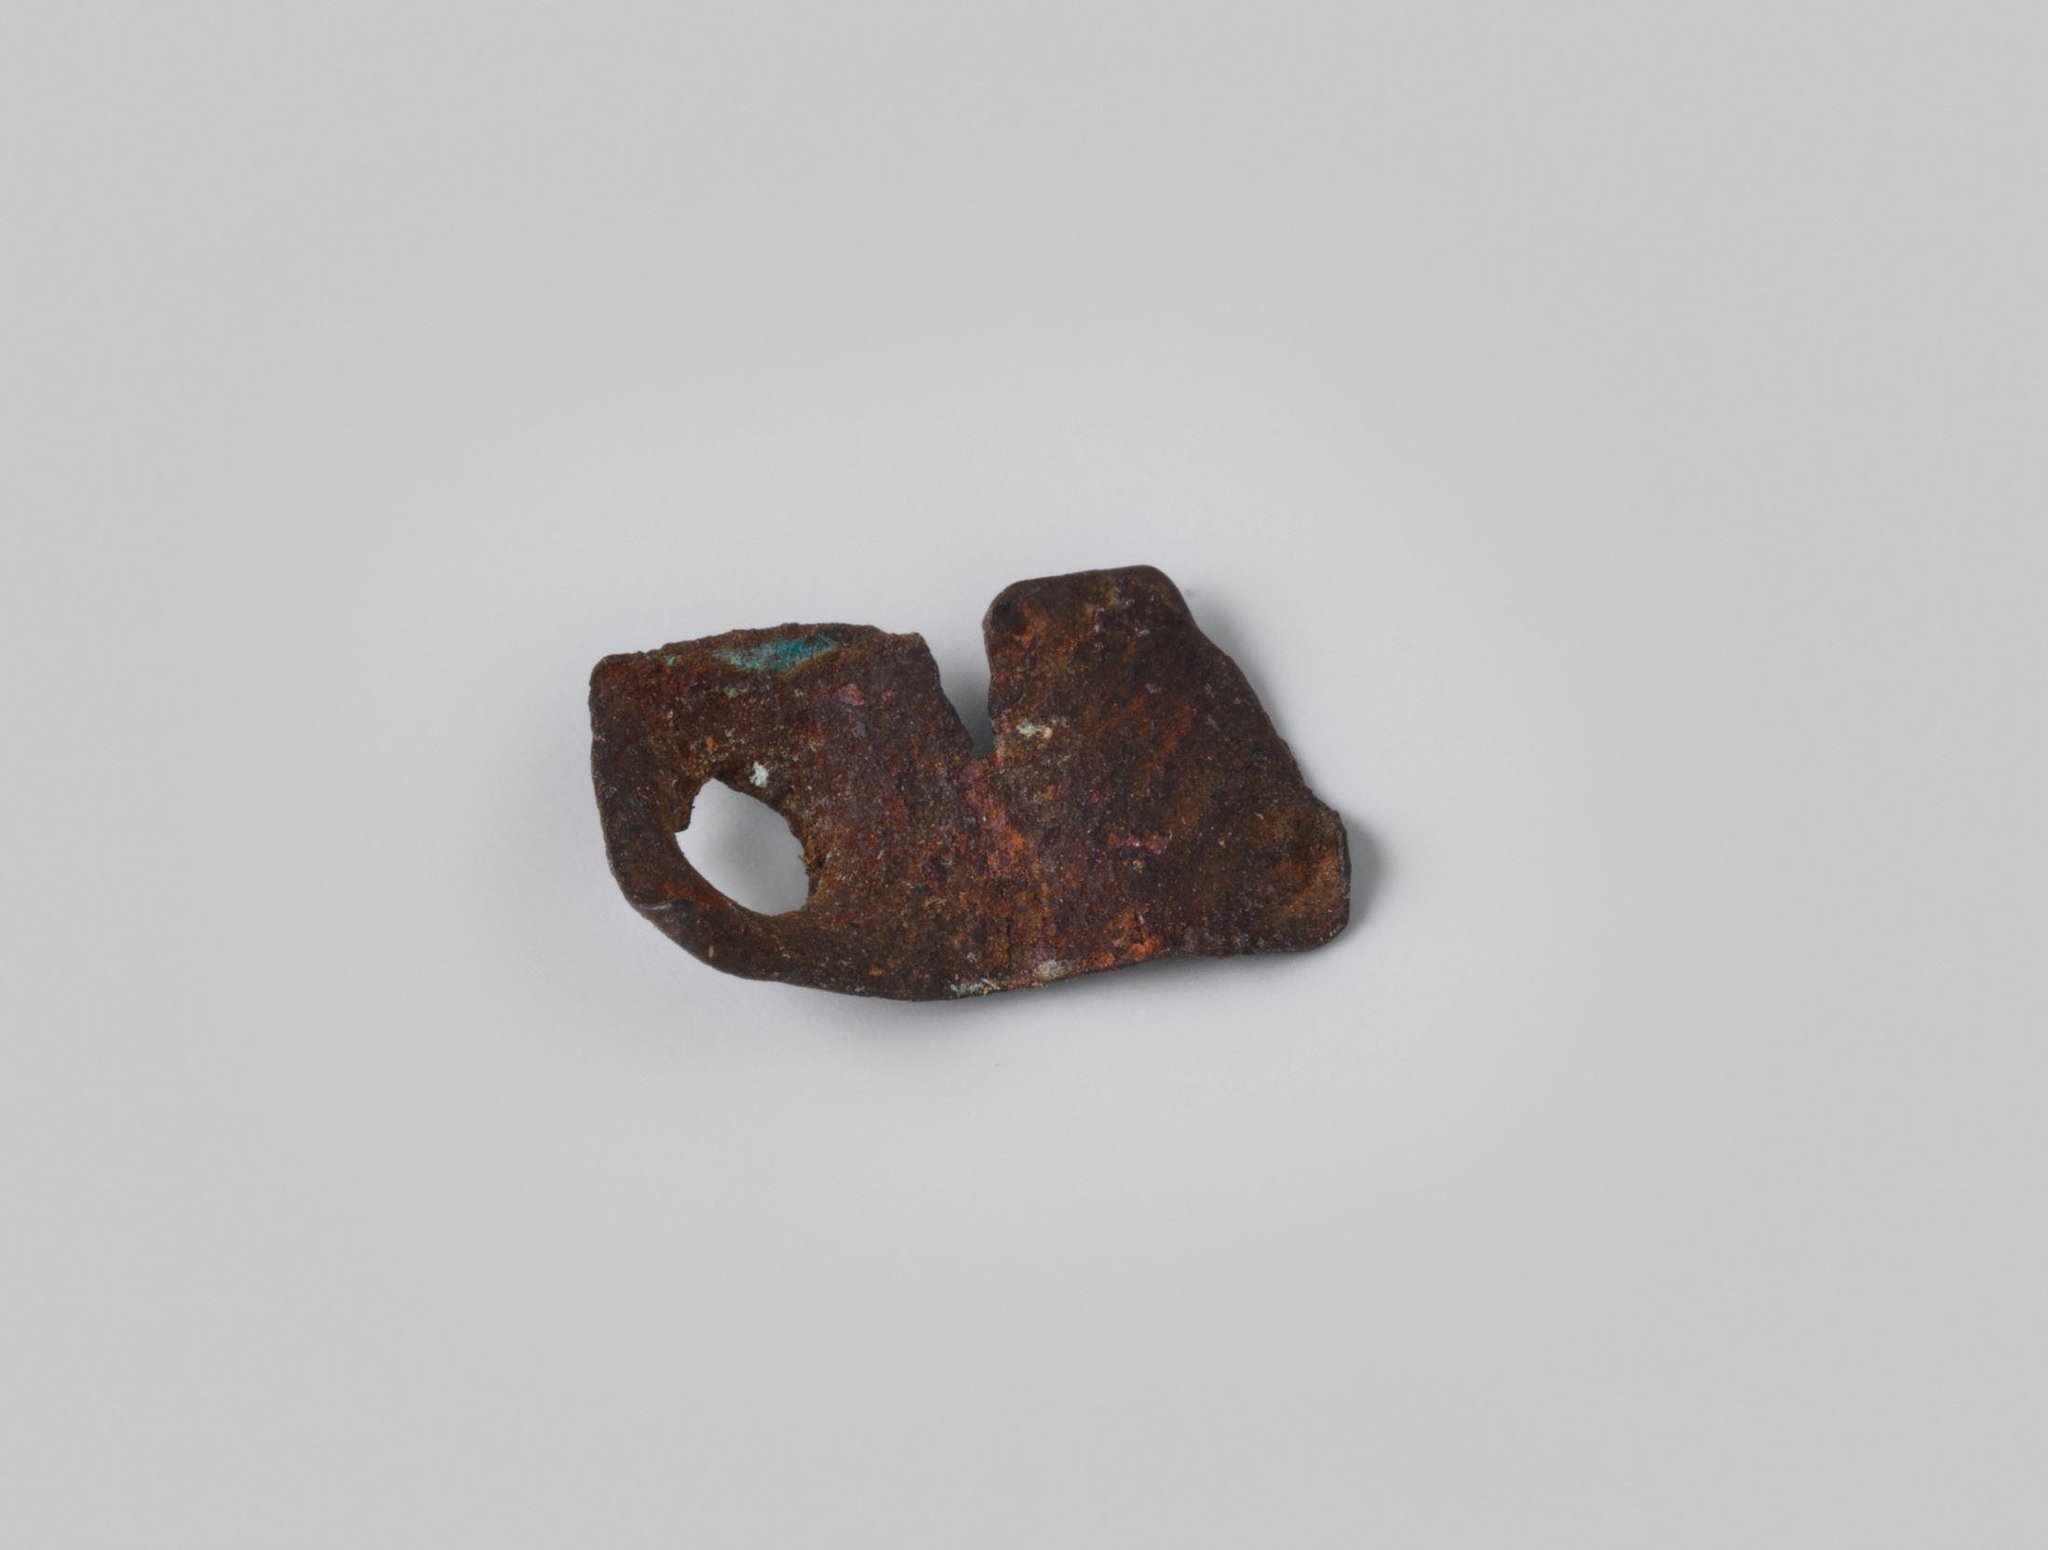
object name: beslag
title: Fragment beslag van koper uit het wrak van de Oost-Indiëvaarder Hollandia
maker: Anonymous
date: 1700-1743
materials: copper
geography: netherlands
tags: verenigde oostindische compagnie, hollandia (schip), annet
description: Varied parts or fragments, strips and strip-shaped fragments; fragm.